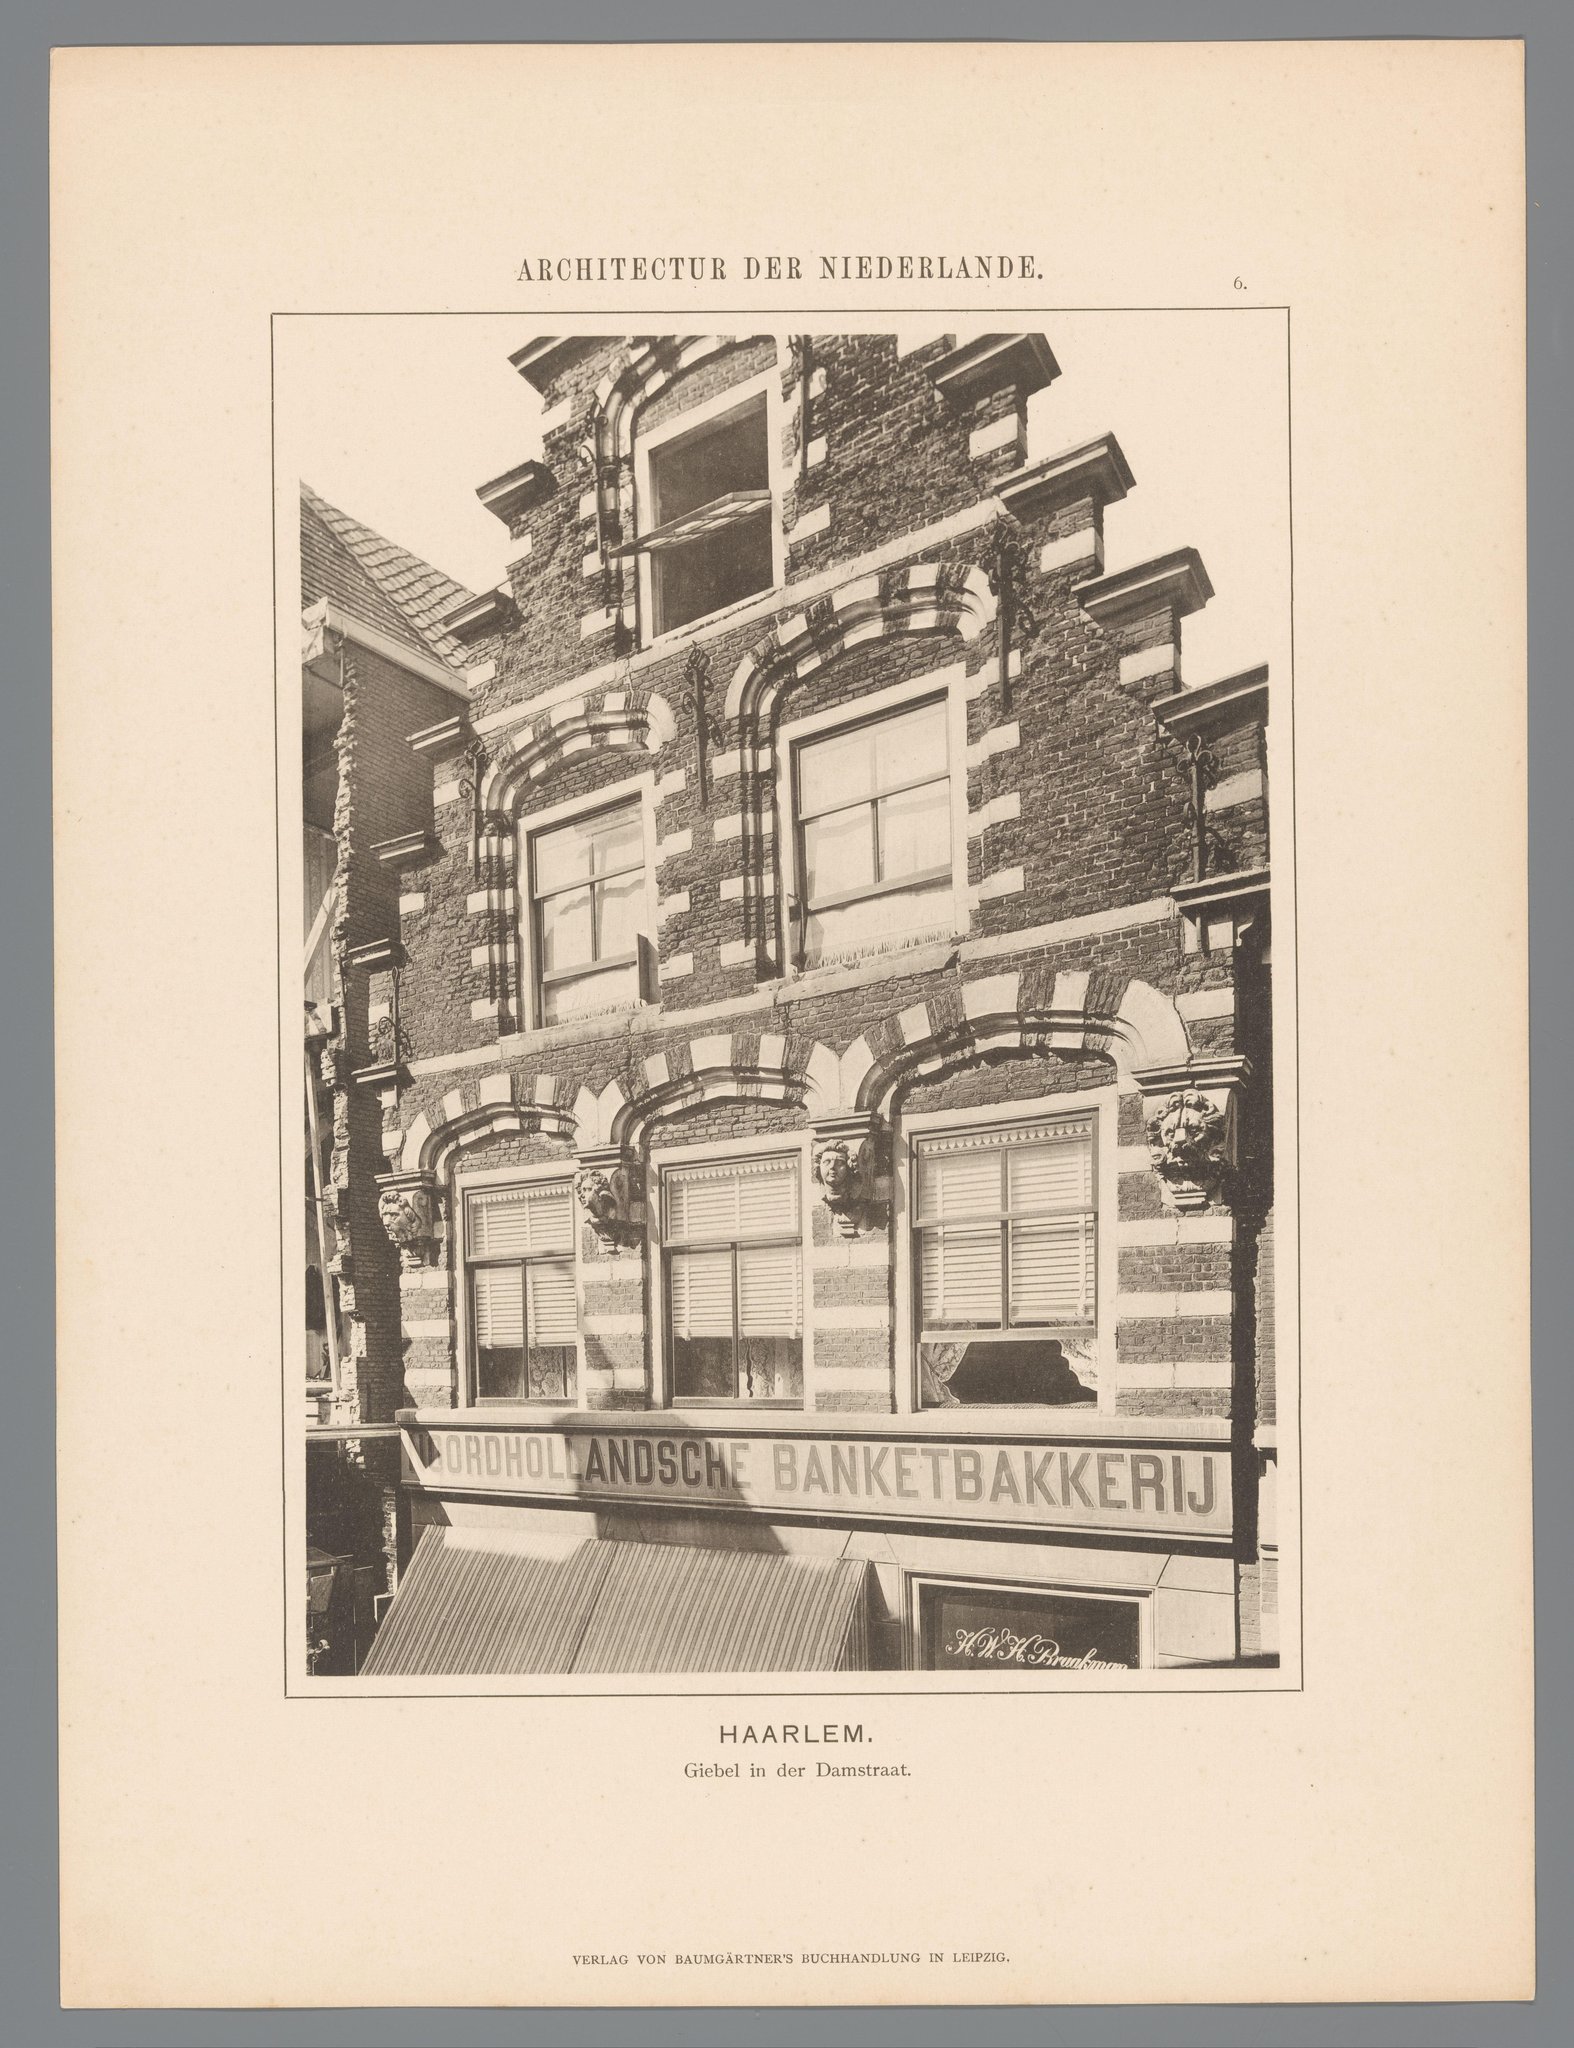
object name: photomechanical print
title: Gezicht op een gevel in de Damstraat in Haarlem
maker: Anonymous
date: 1894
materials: paper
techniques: photograph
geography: leipzig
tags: urban housing, front façade, haarlem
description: Afdruk uit: Krook, L. Architectur der Niederlande. Leipzig: Baumgärtner's Buchhandlung, 1894.